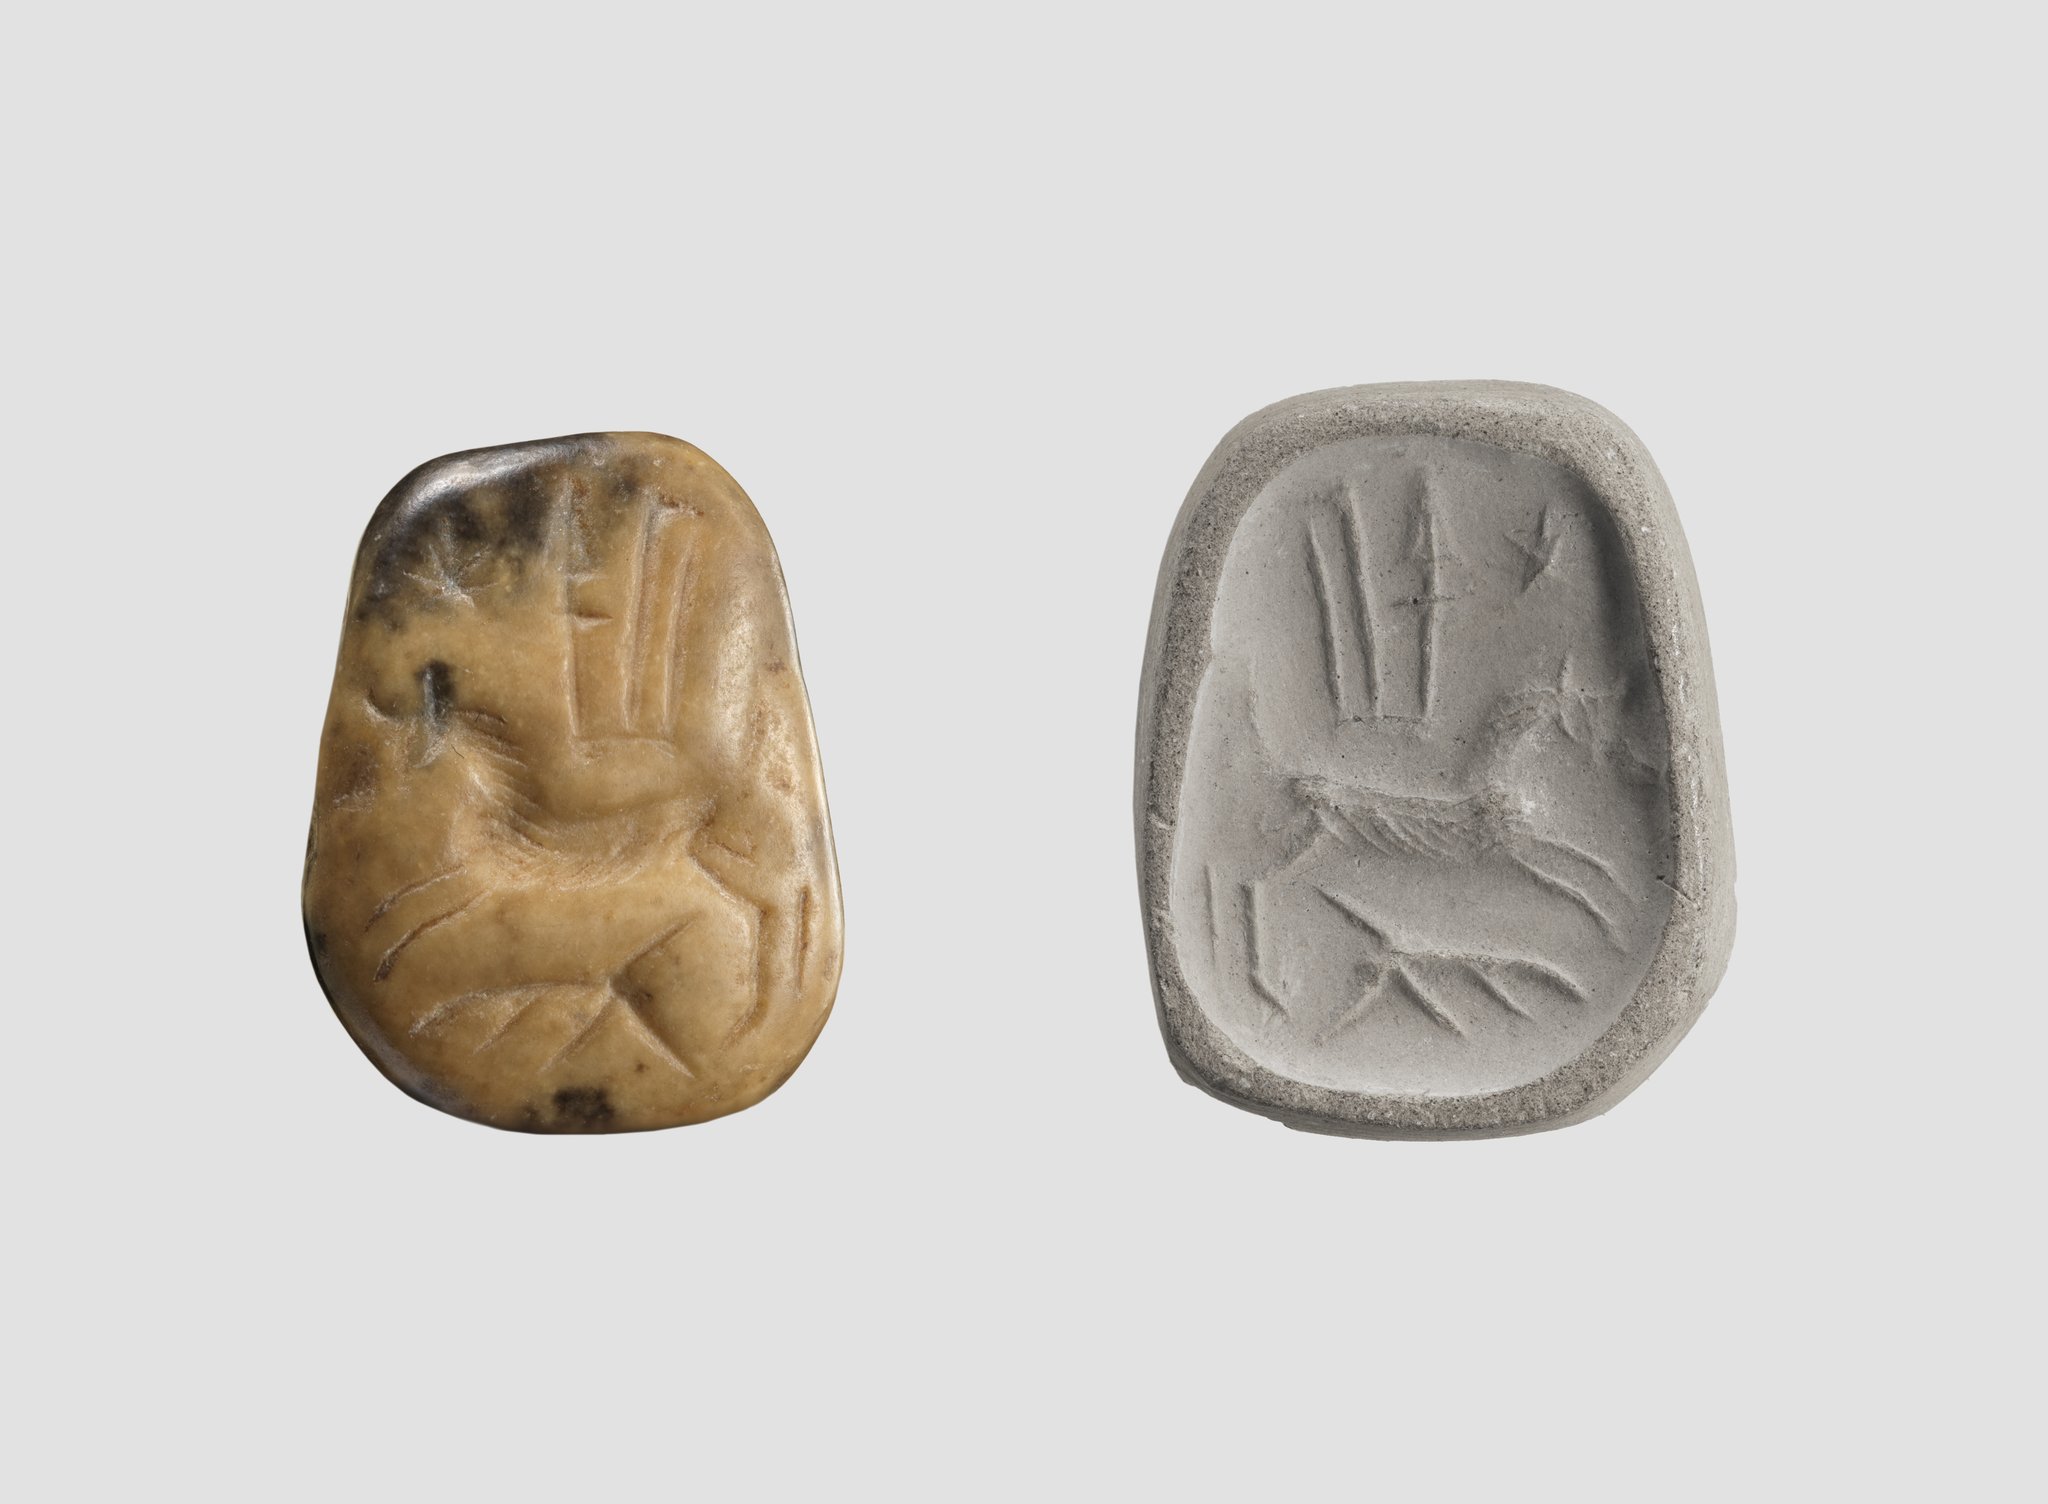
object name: stamp seal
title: Stamp seal (octagonal pyramid, worn) with divine symbols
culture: assyrian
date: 734-601 BCE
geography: mesopotamia or syria